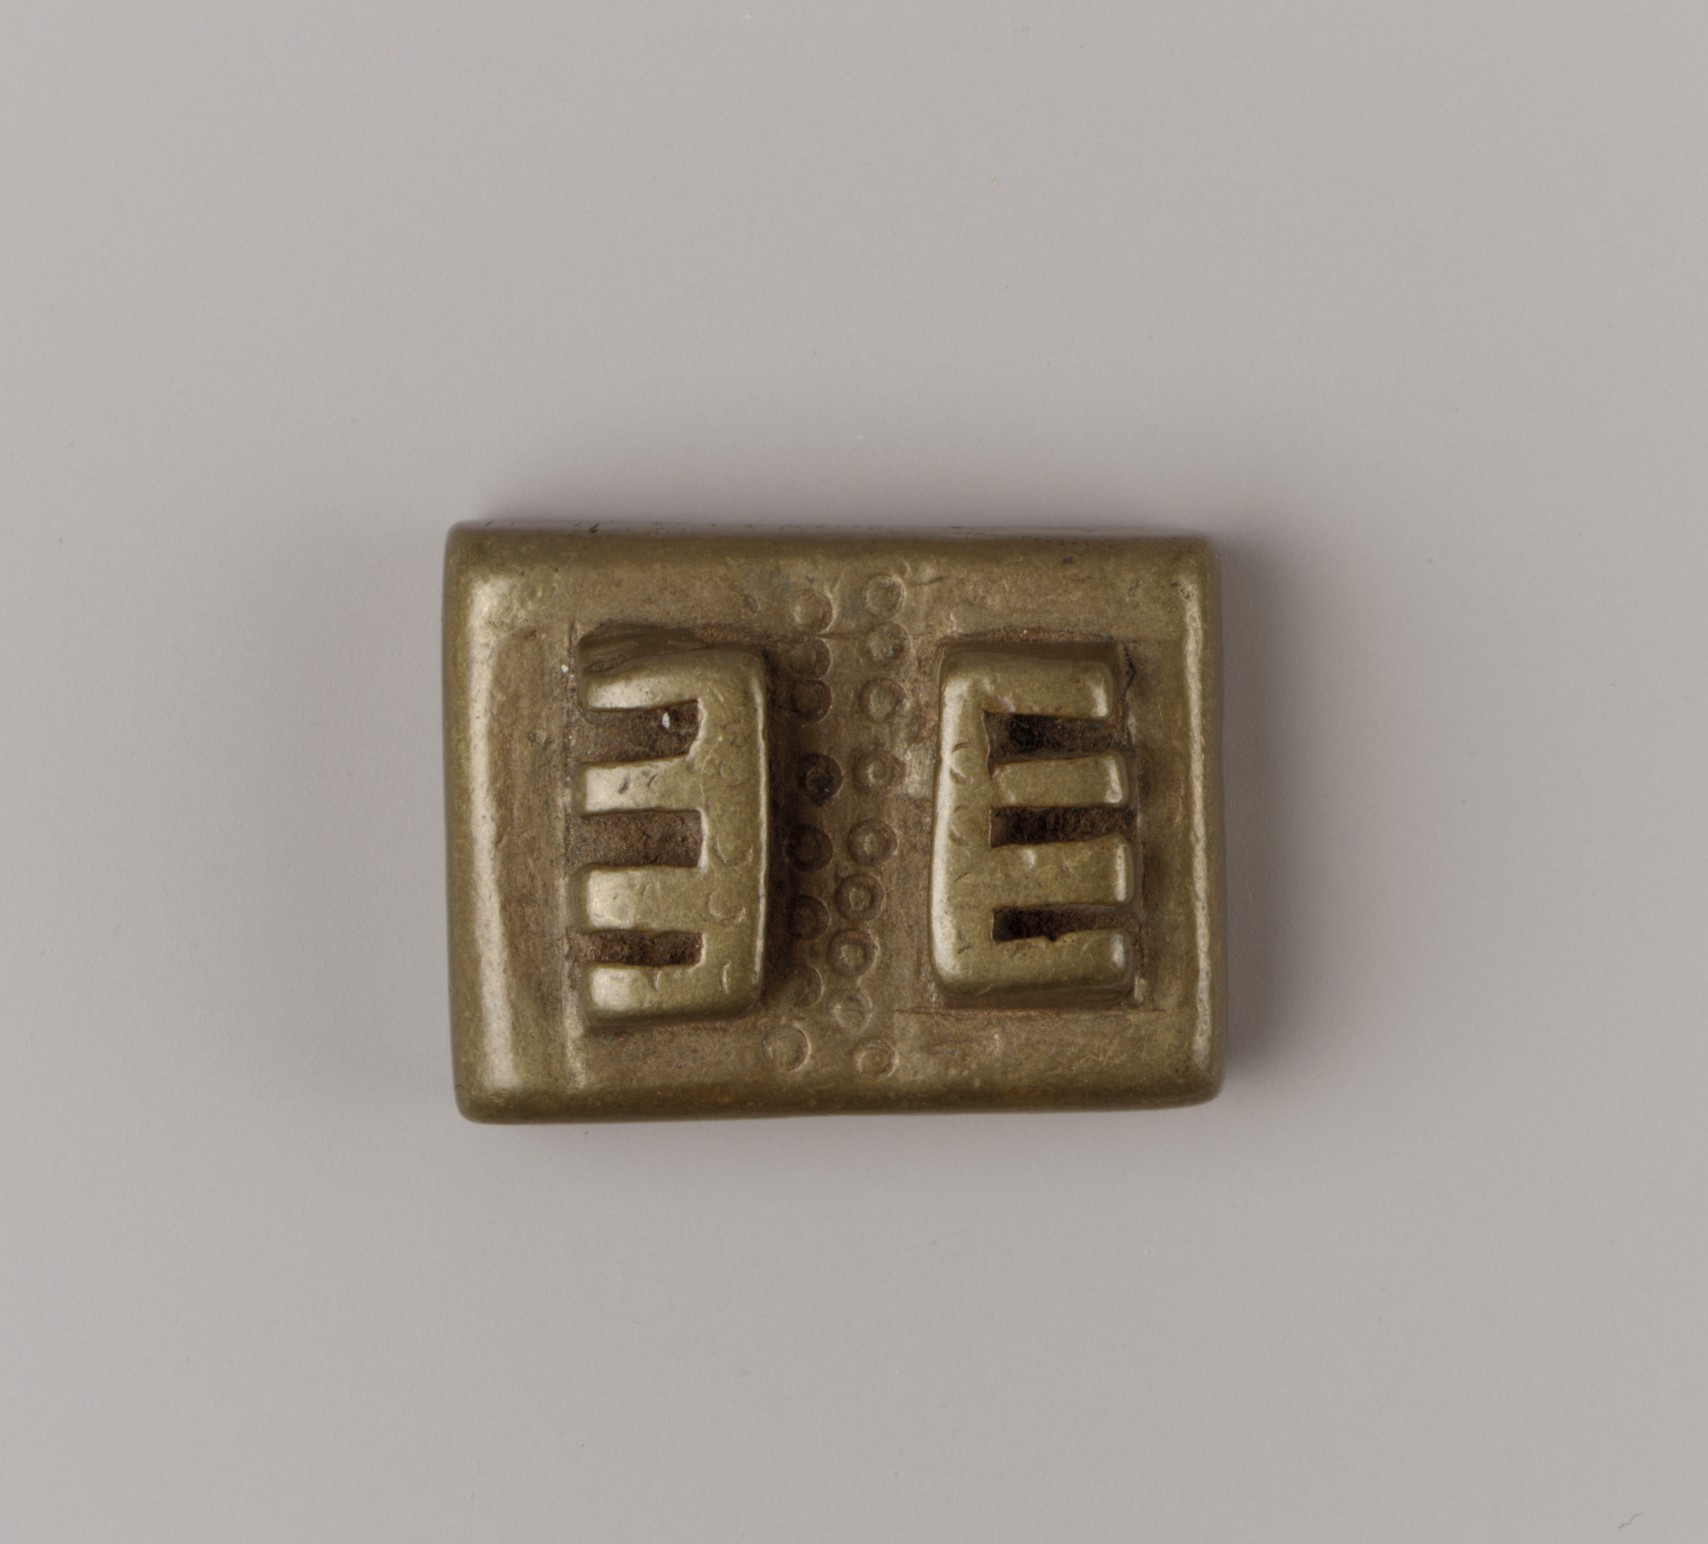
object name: weight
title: Geometric gold weight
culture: akan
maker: akan artist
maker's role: artist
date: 1501-1700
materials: brass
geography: côte d’ivoire